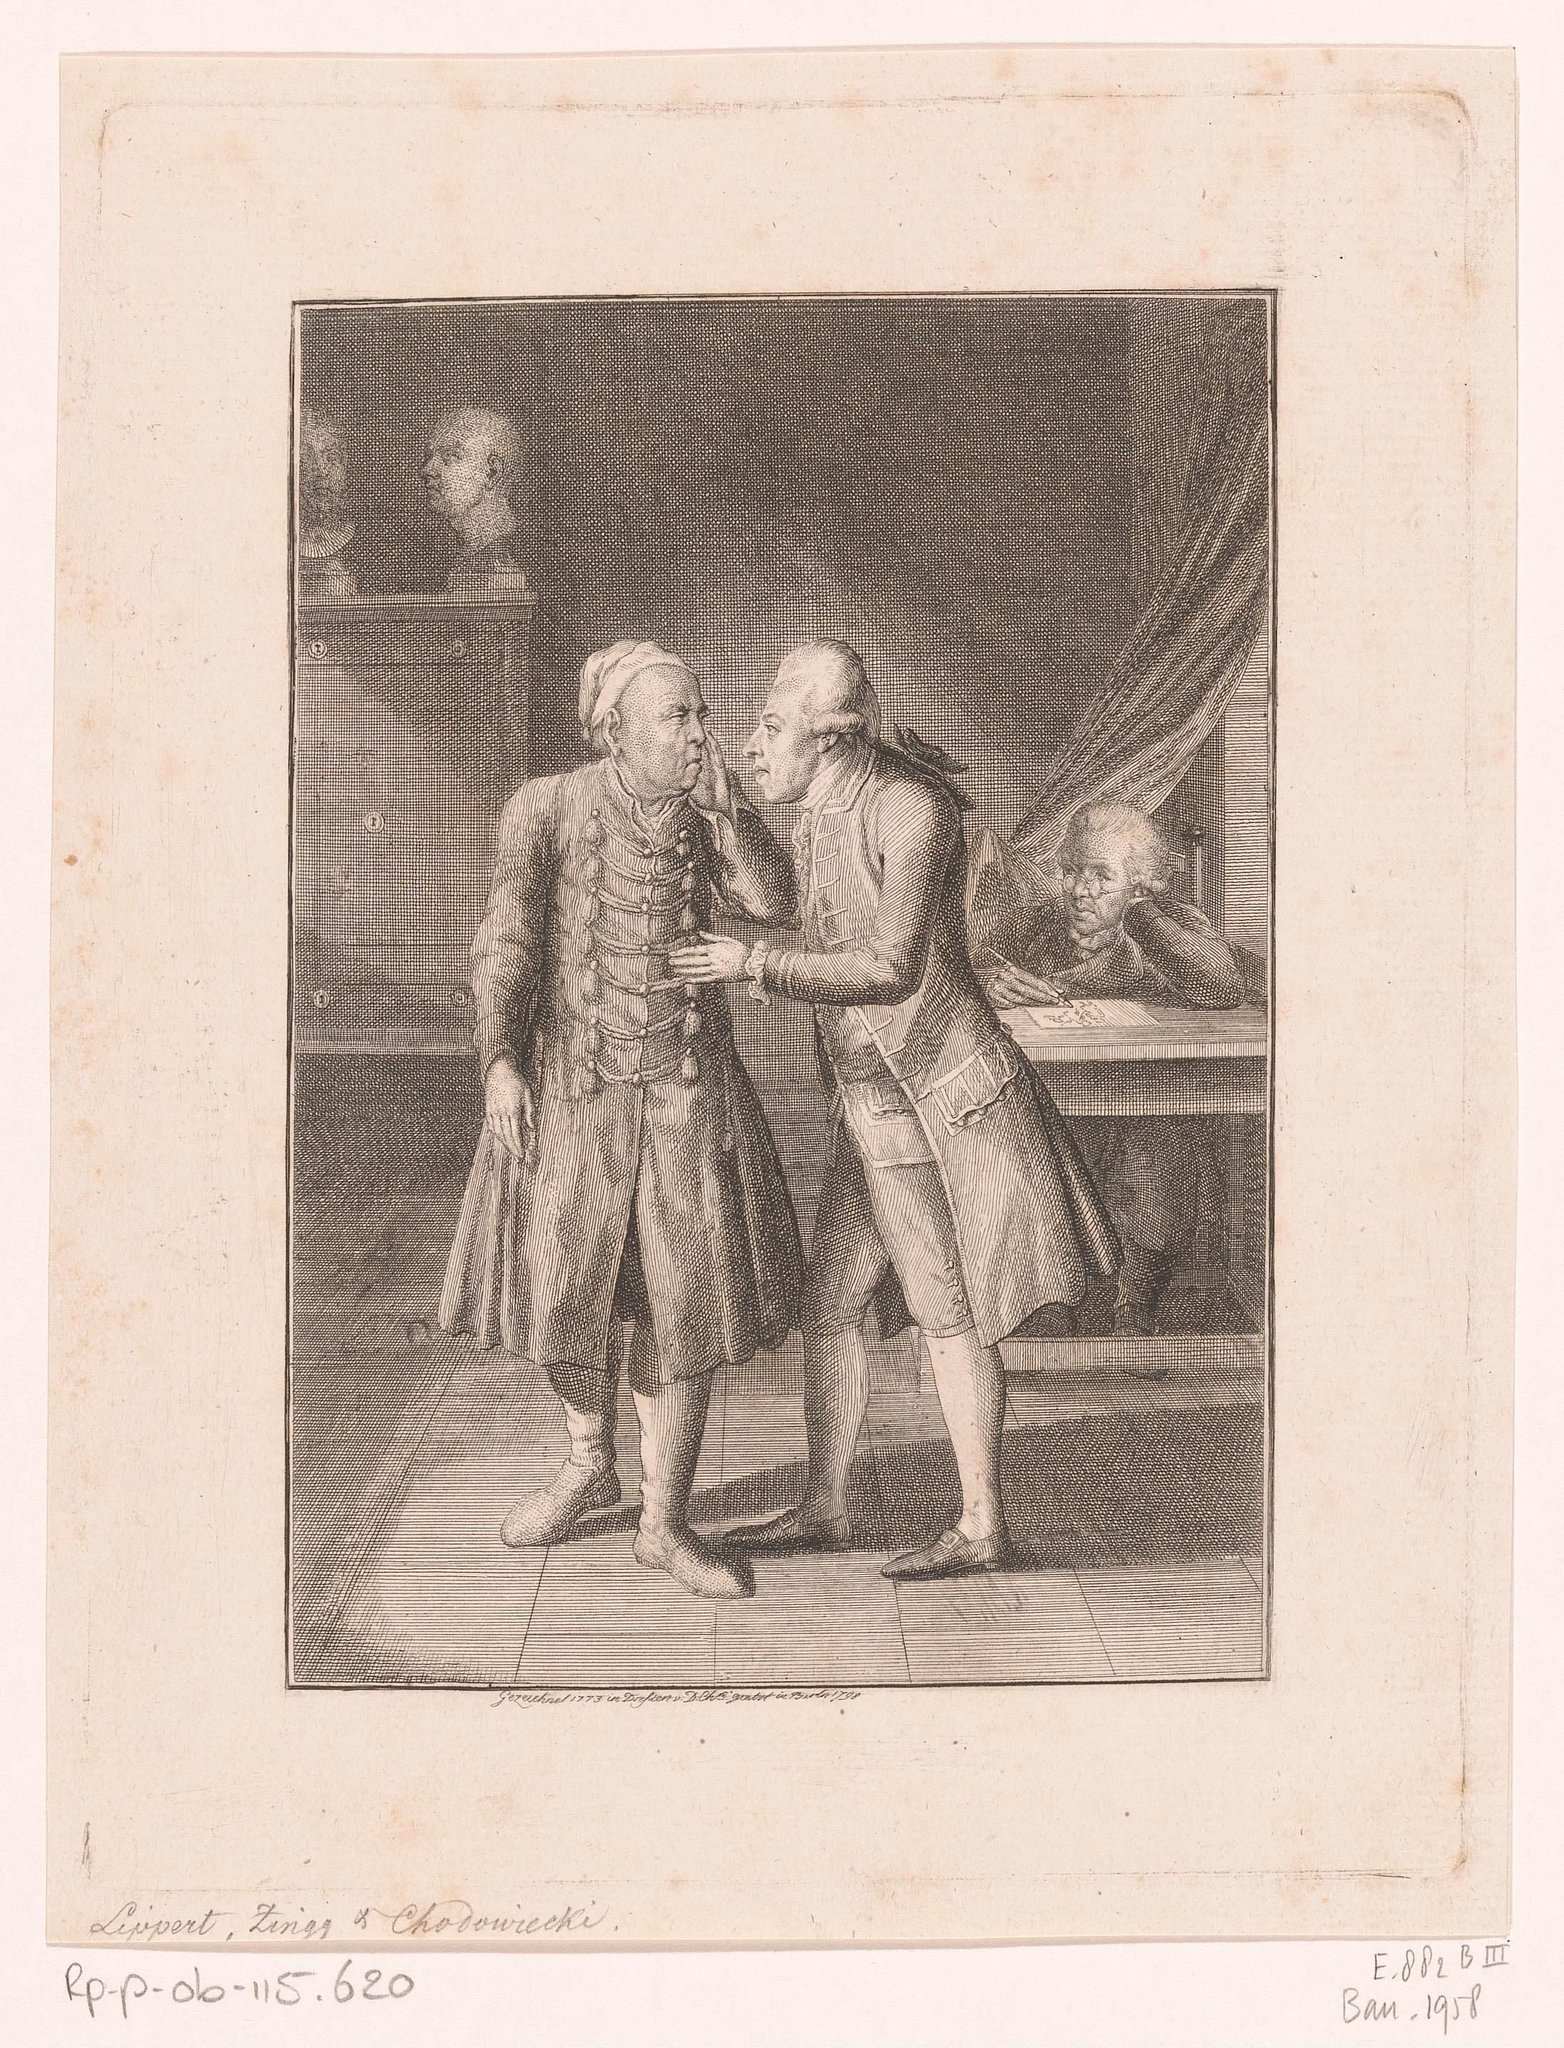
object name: print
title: Chodowiecki schetst Lippert en Zingg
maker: daniel nikolaus chodowiecki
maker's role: draughtsman, print maker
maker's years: 1726-1801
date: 1773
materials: paper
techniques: etching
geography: berlin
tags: adrian zingg, philip daniël lippert, berlin, print maker, draughtsman, daniel nikolaus chodowiecki, drawing, sketch, circle, club of artists, chest, bust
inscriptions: collector's mark: Lugt 2228